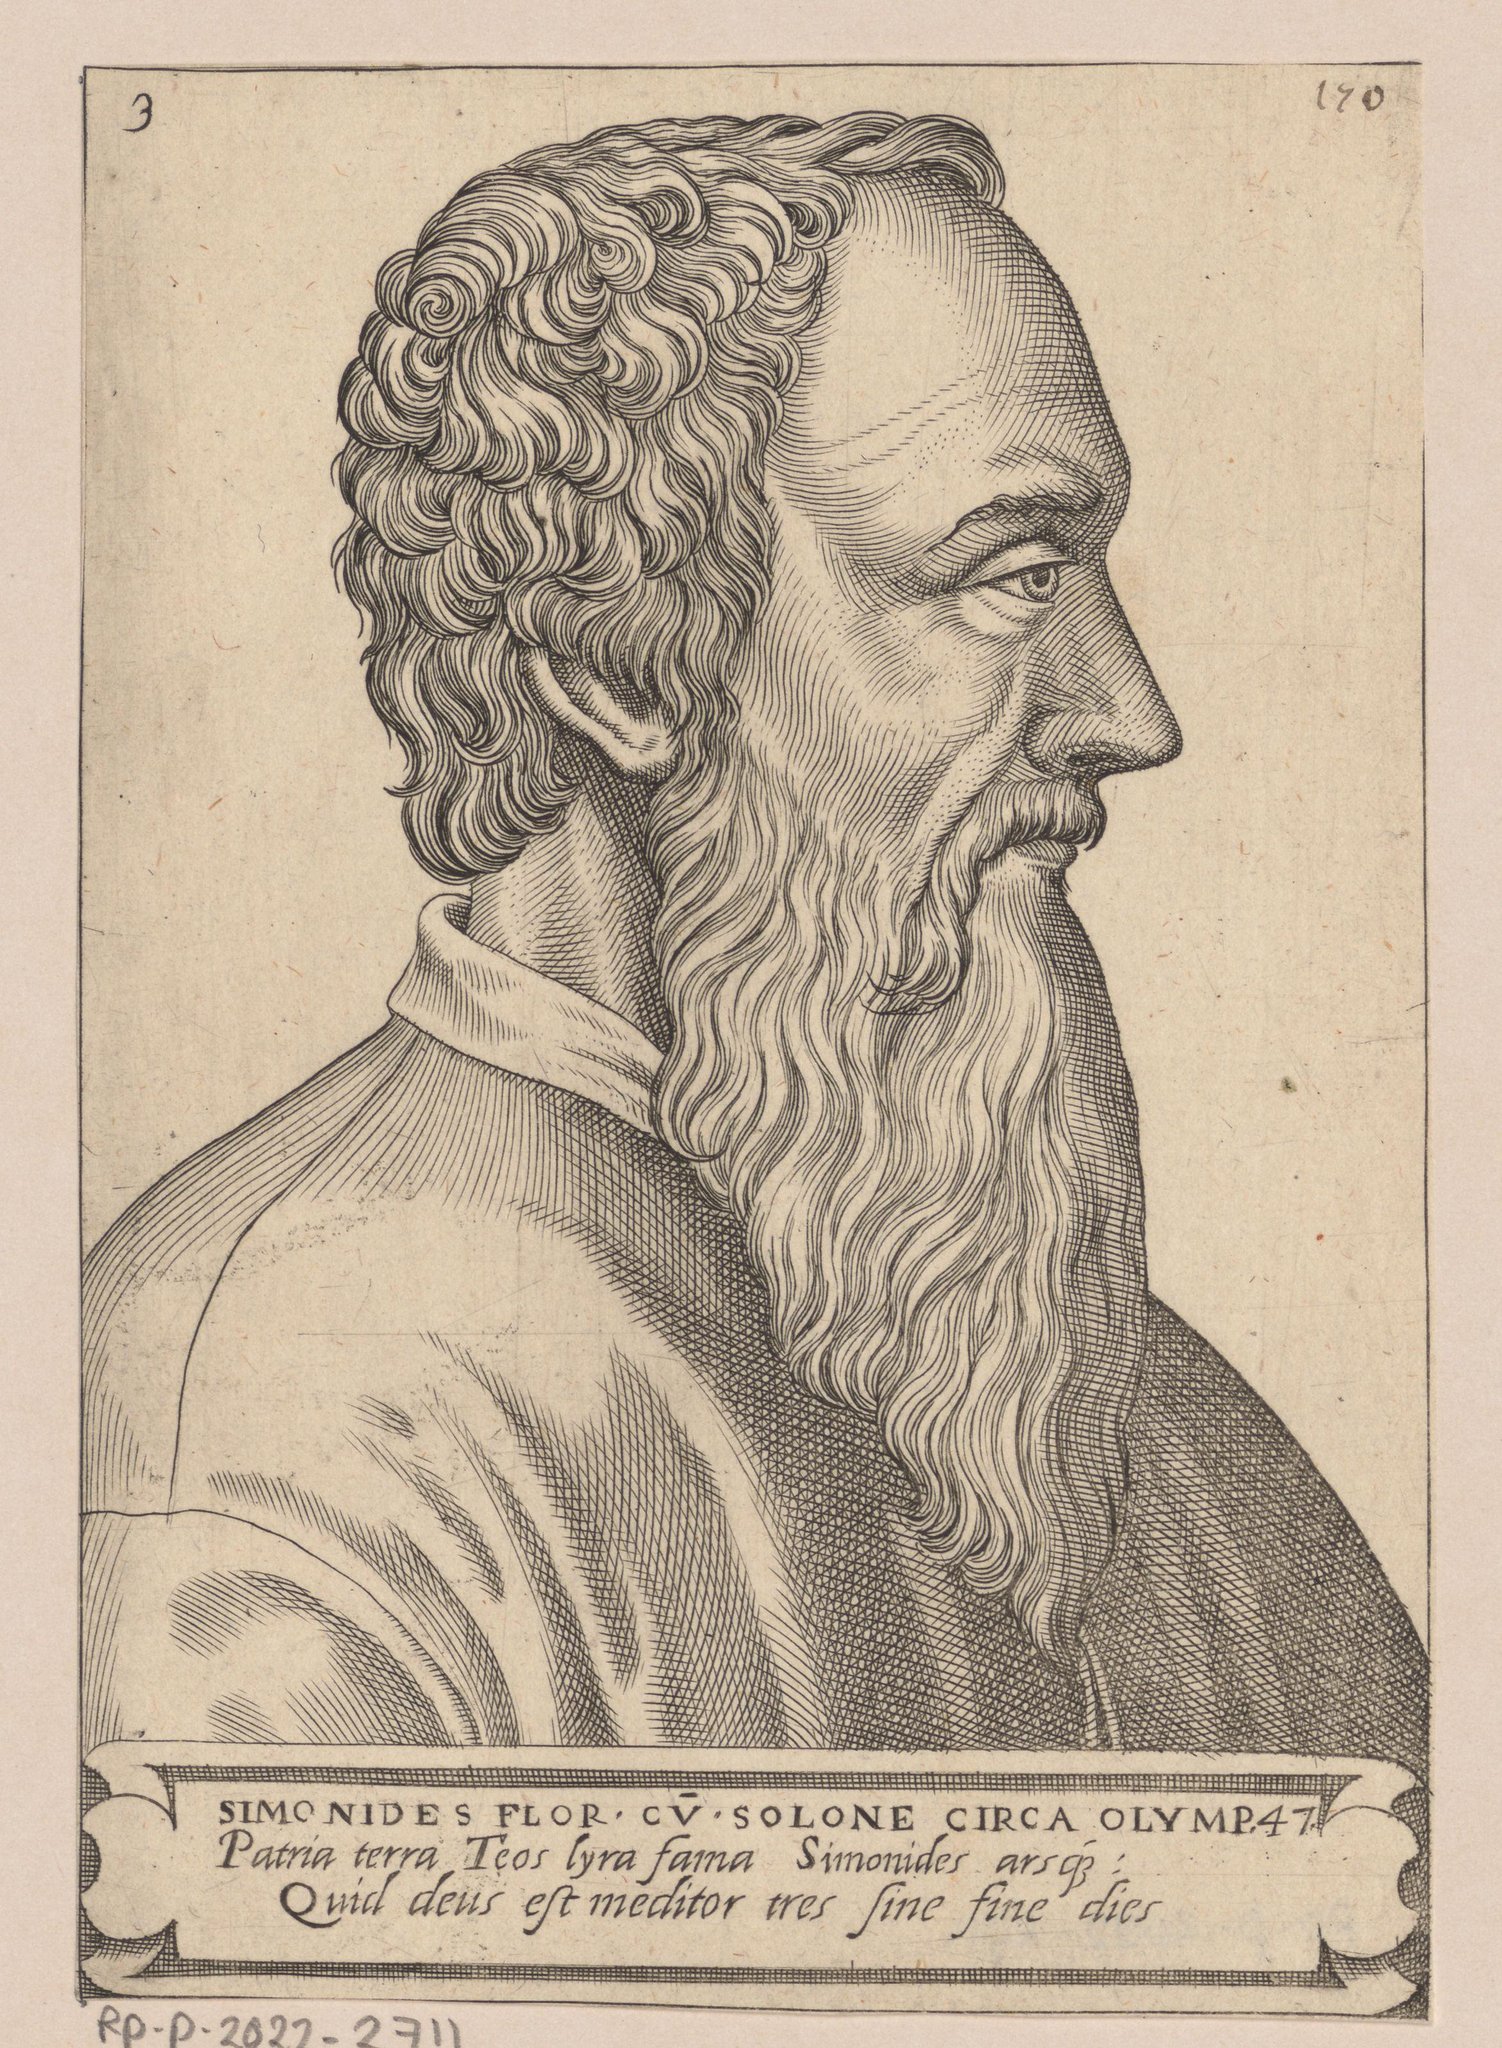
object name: print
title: Portret van Simonides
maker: Anonymous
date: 1600-1699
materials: paper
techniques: engraving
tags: historical persons, writer, poet, author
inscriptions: number: ‘170’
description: Met drieregelig onderschrift in het Latijn. Genummerd linksboven: 3.